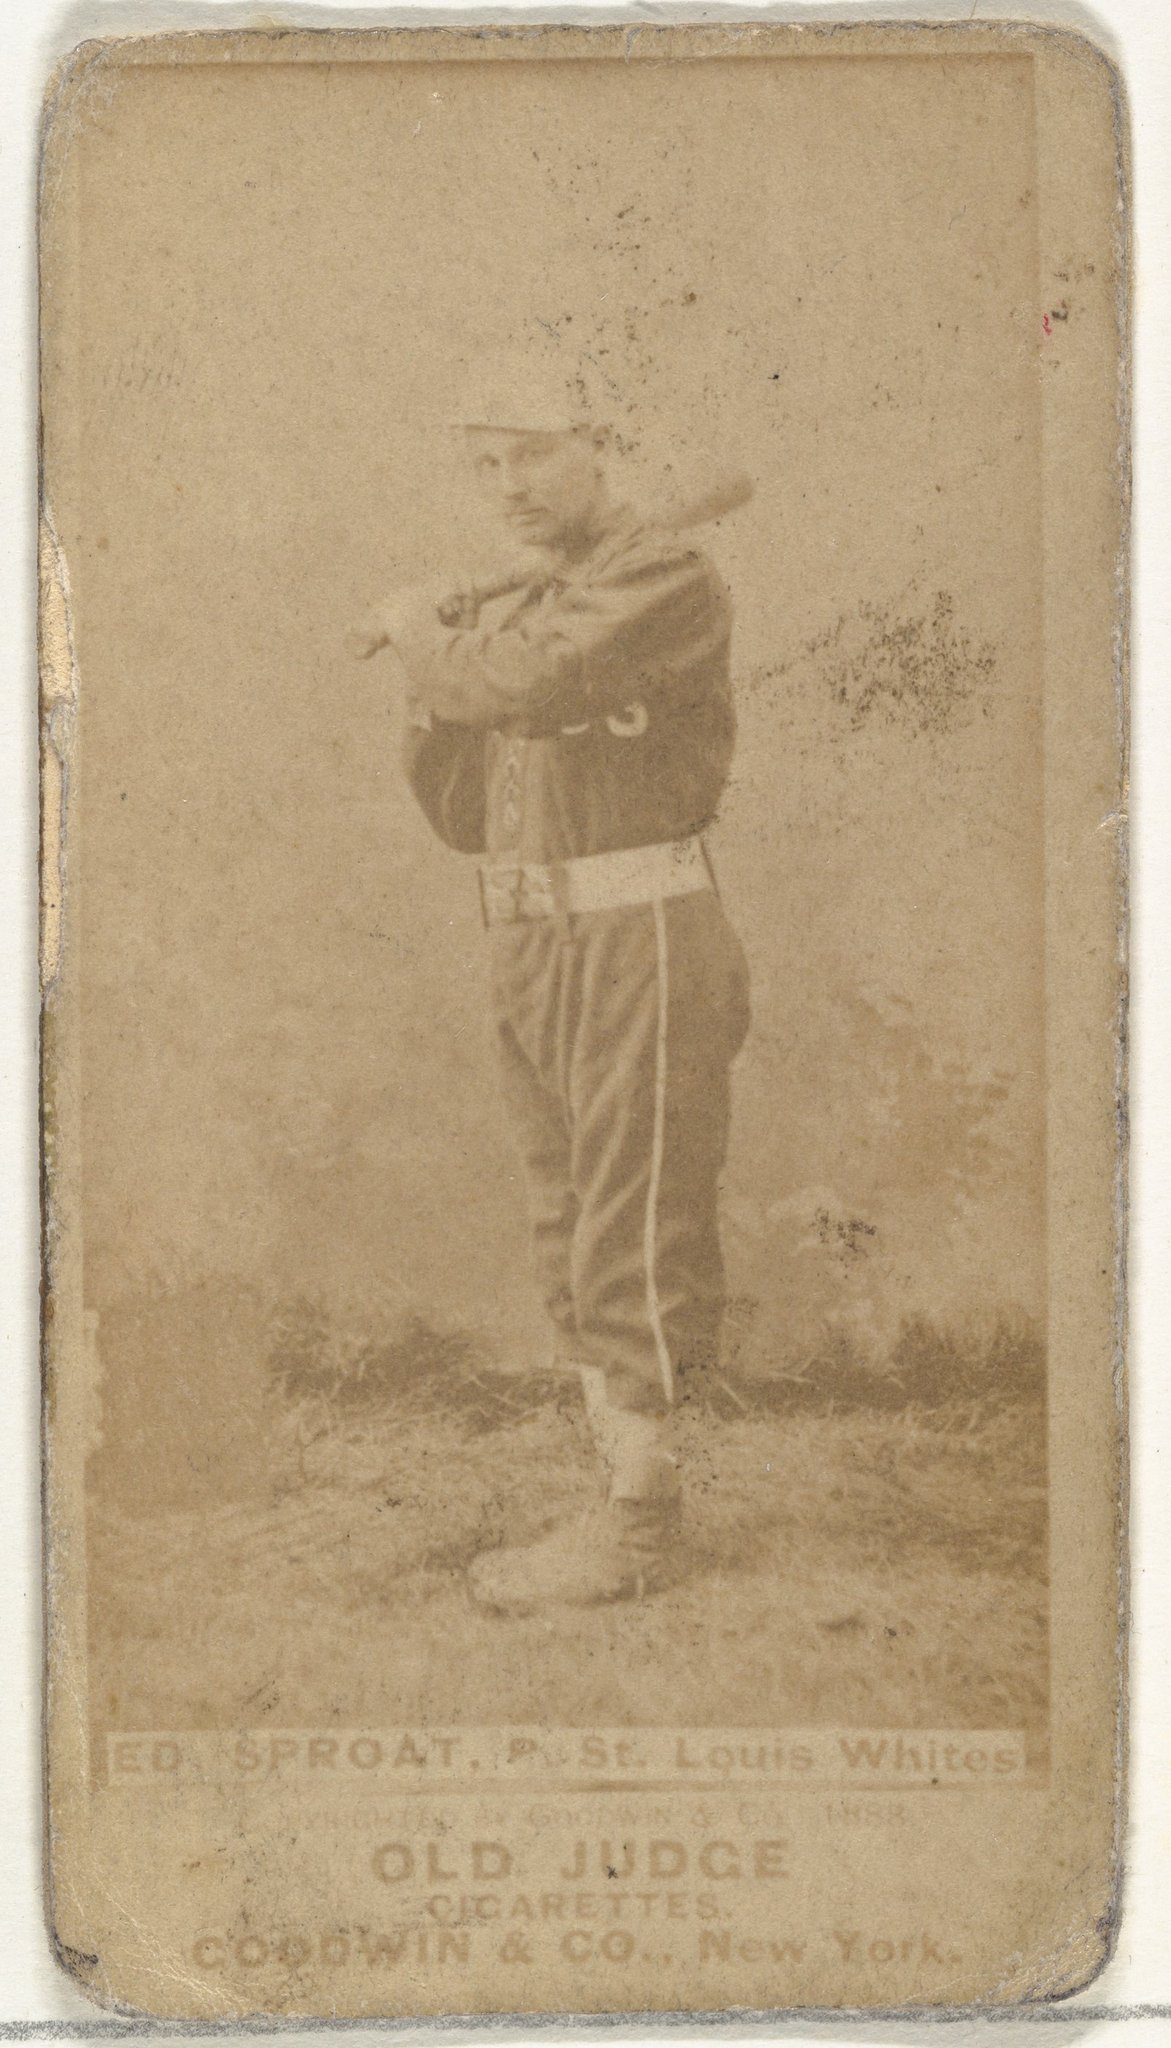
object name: baseball card, photograph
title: Sproat, Pitcher, St. Louis Whites, from the Old Judge series (N172) for Old Judge Cigarettes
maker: goodwin & company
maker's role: publisher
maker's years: 1850-1950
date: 1888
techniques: albumen silver print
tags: men,portraits,baseball,athletes